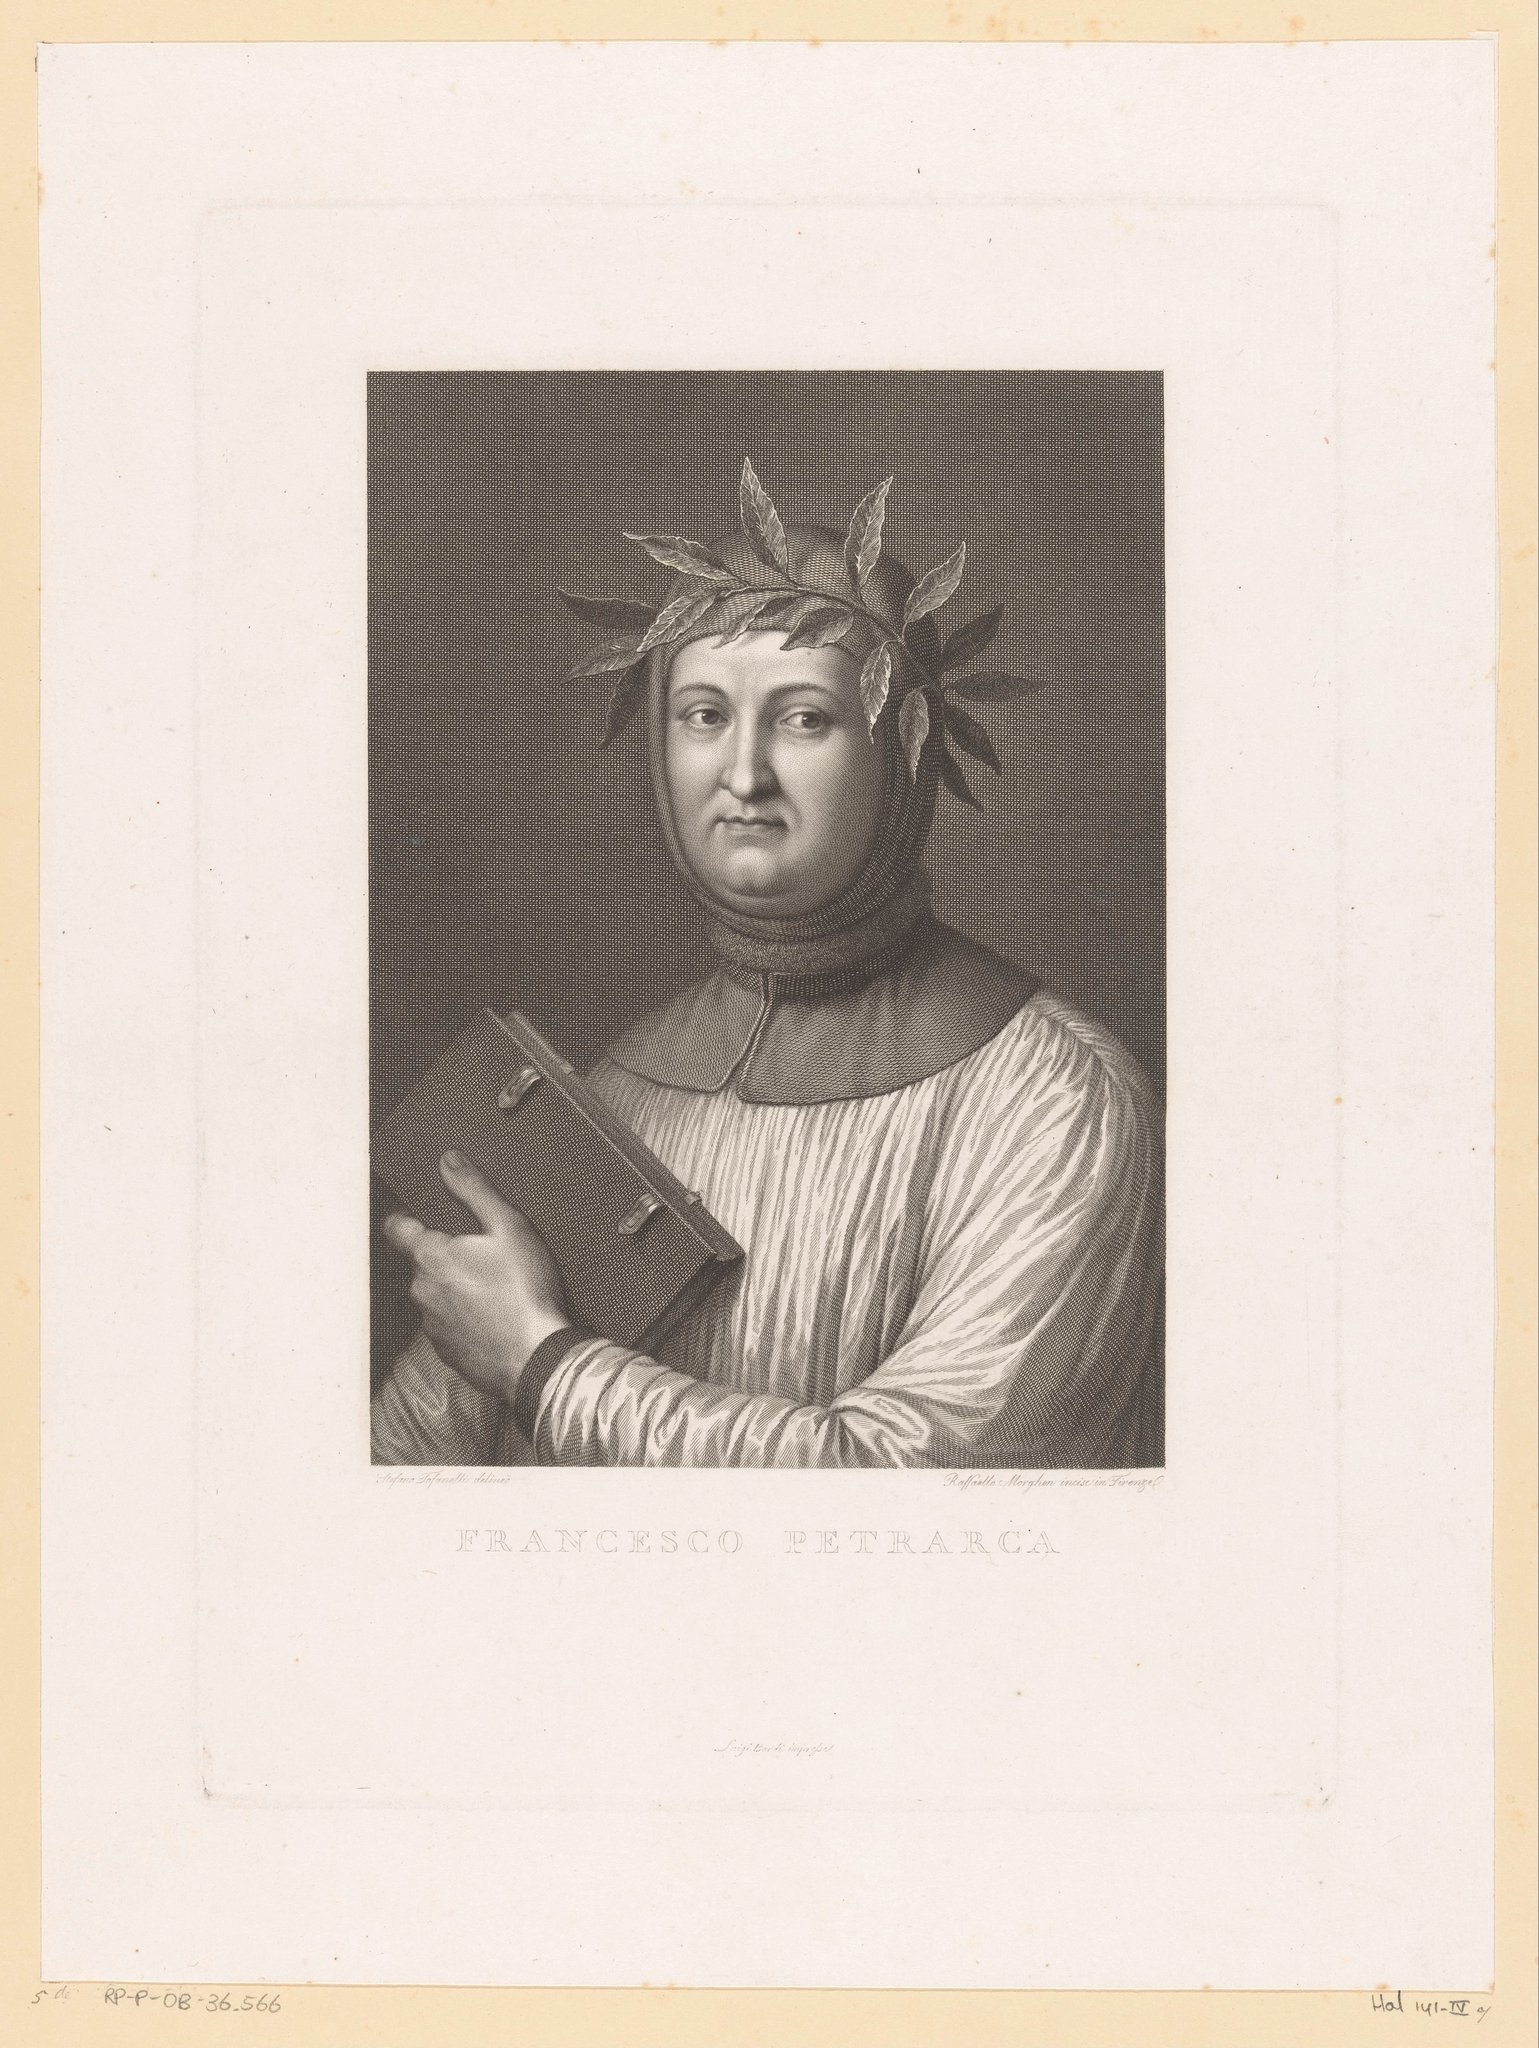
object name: print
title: Portret van dichter Francesco Petrarca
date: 1768-1833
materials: paper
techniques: engraving, etching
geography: florence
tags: francesco petrarca, historical persons, portrait of a writer, writer, poet, author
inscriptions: collector's mark: Lugt 12